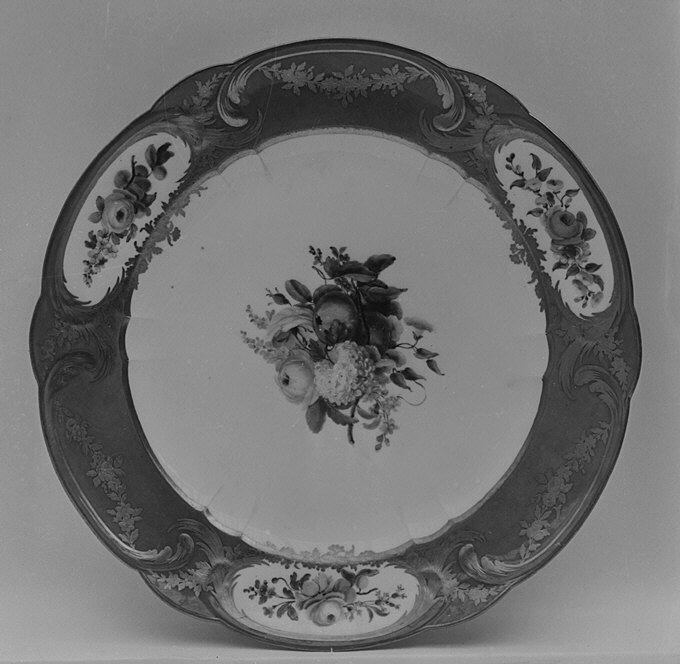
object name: plate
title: Plate (Assiette à palmes) (1 of 102) (part of a service)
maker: sèvres manufactory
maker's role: manufactory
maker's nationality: french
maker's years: 1740-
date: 1786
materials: soft paste porcelain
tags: flowers